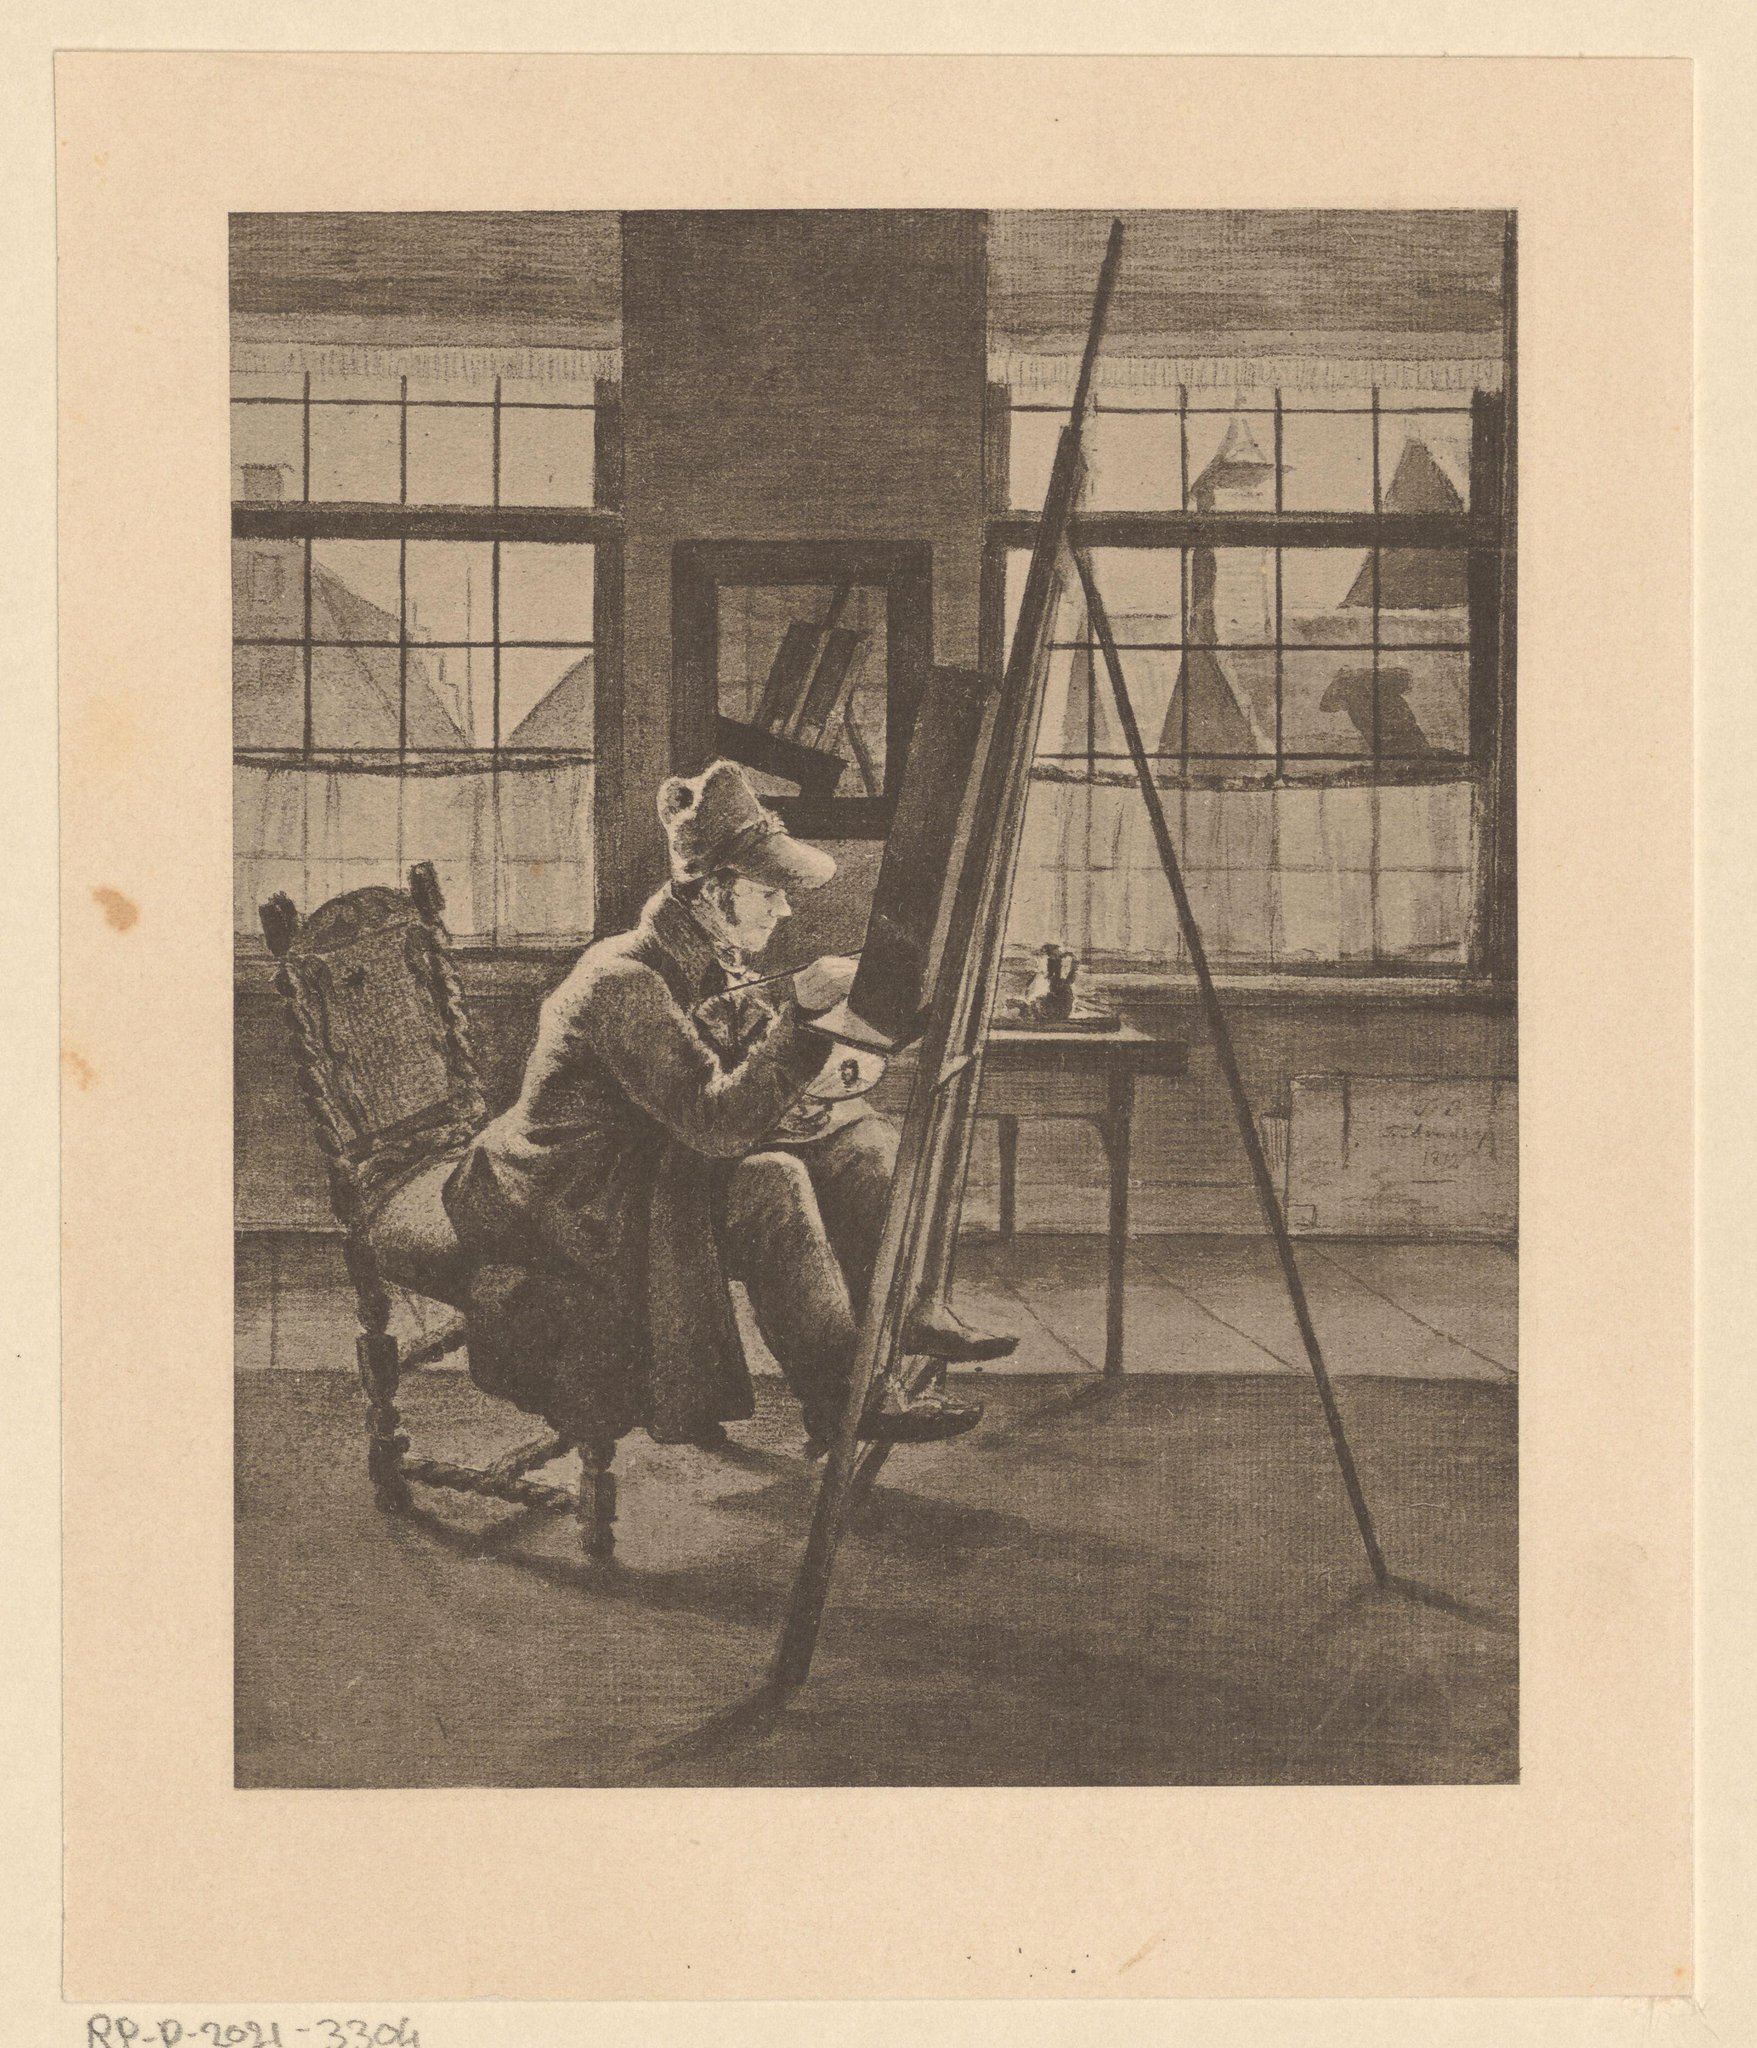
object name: photomechanical print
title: Portret van Jan Kobell II in zijn atelier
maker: Anonymous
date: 1875-1930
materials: paper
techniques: photograph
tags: delfshaven, amsterdam, painter, print maker, draughtsman, jan kobell (ii), historical persons, workshop, studio ~ painter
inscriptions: collector's mark: Lugt 2760, collector's mark: Lugt 2228